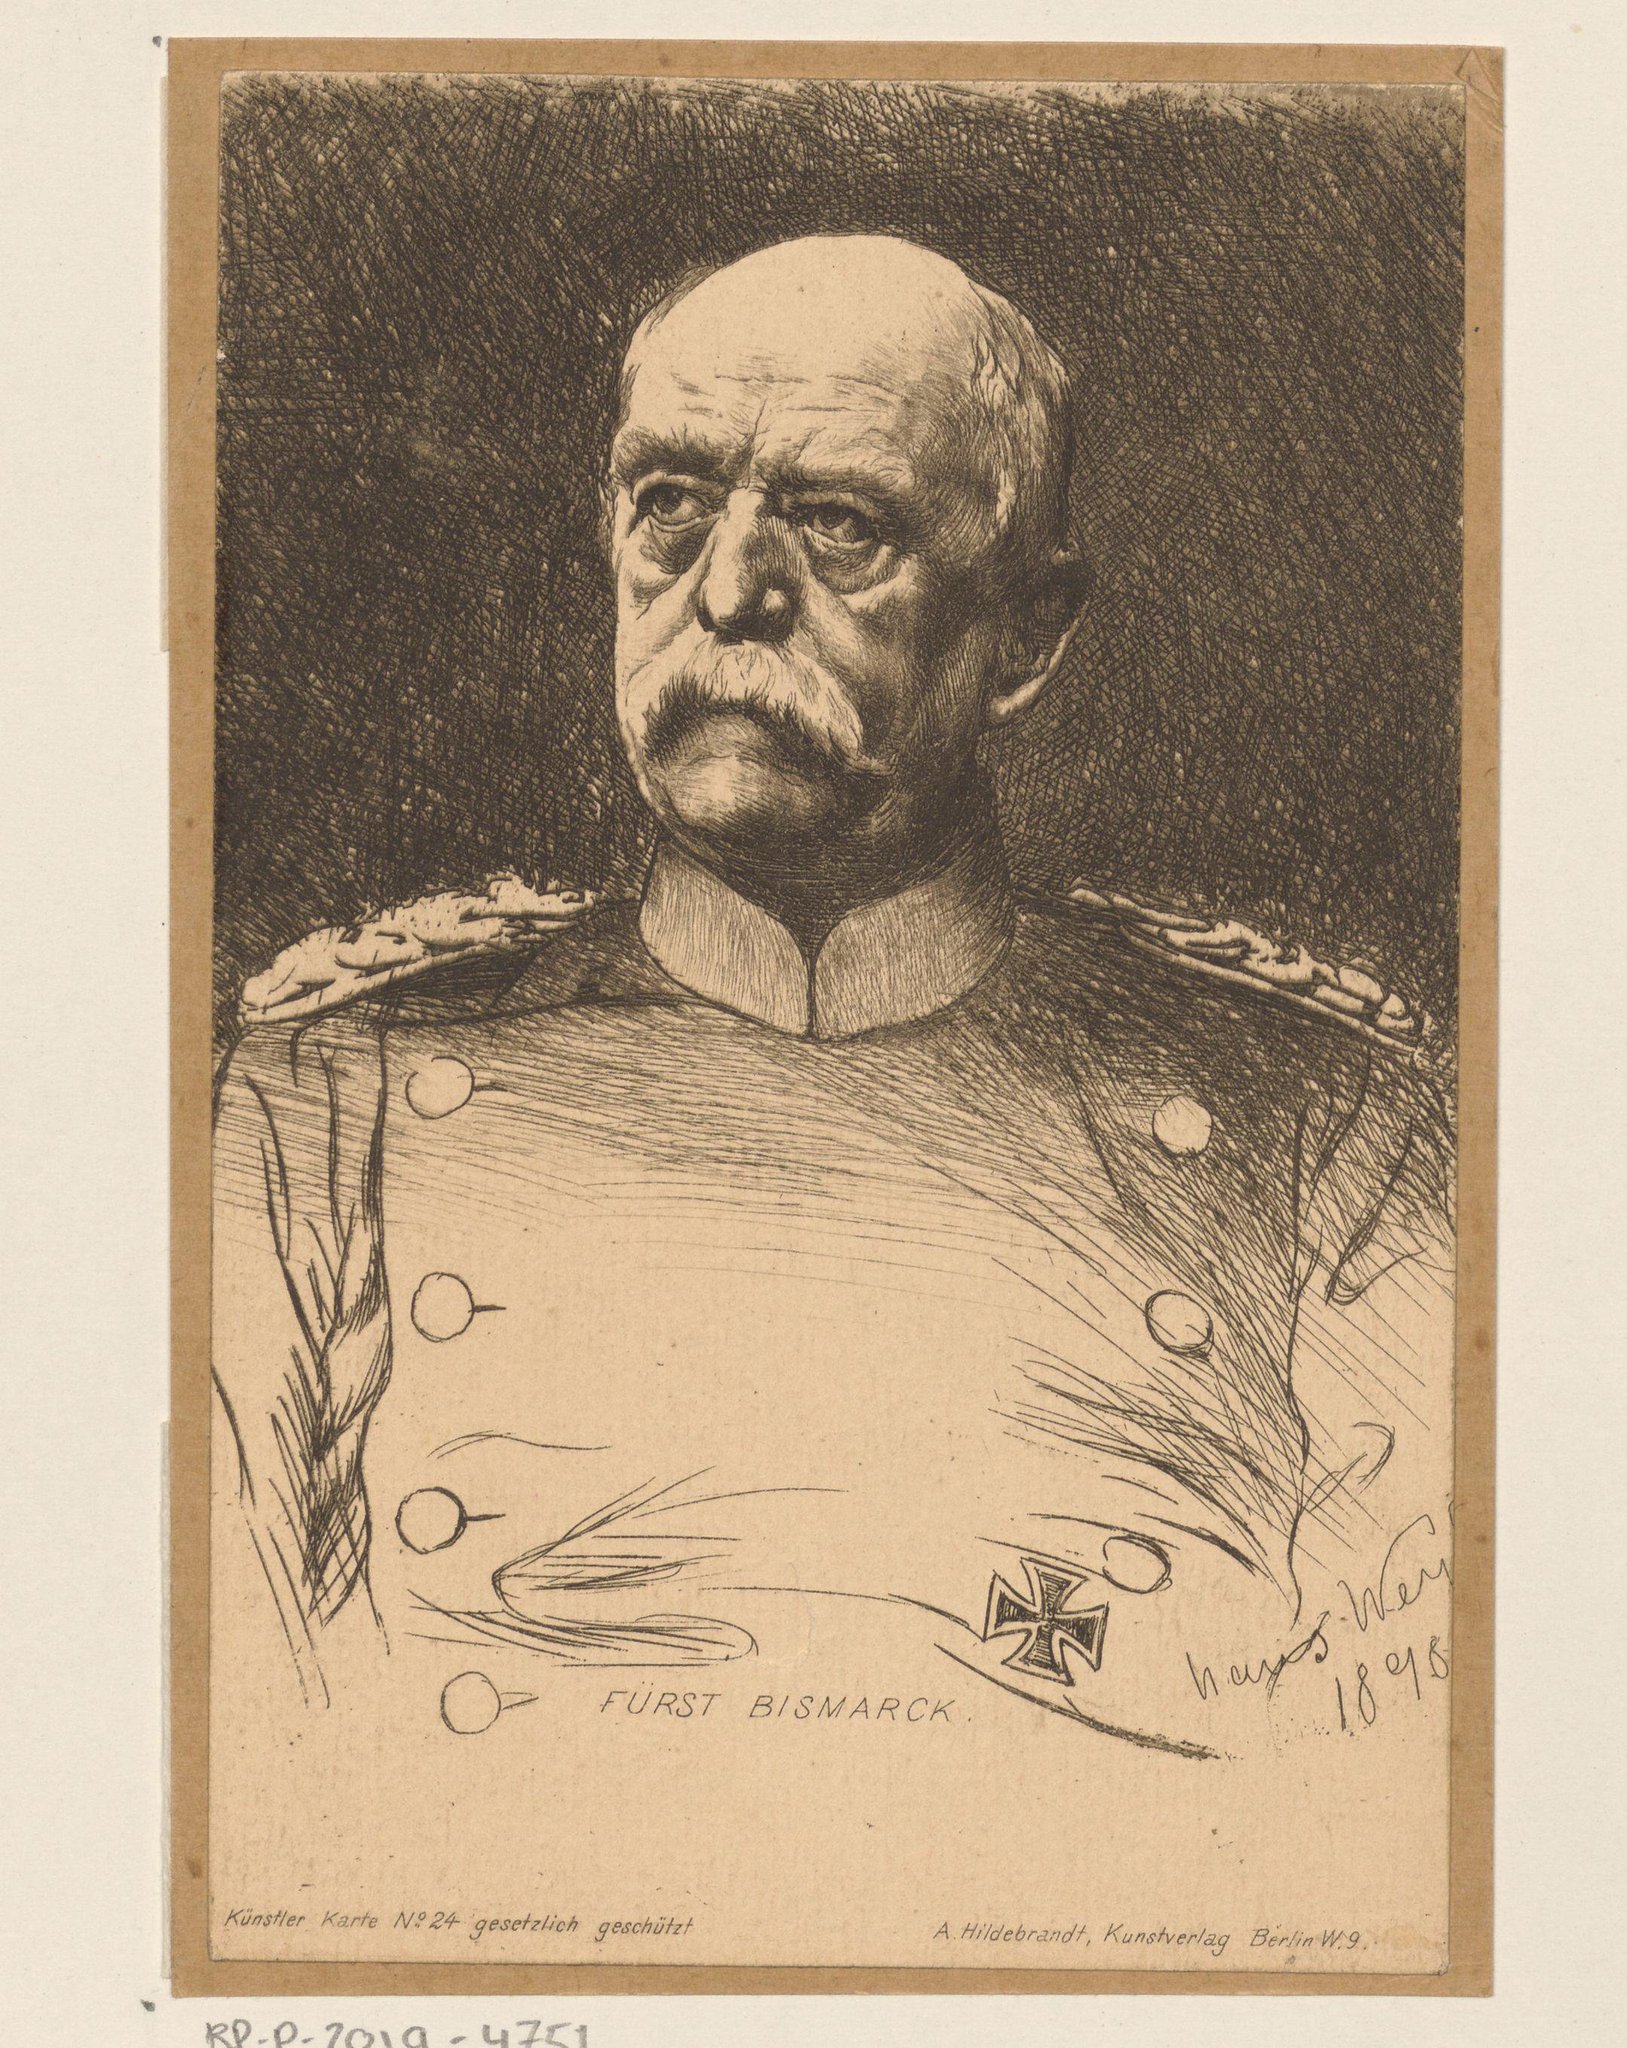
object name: ansichtkaart, prentbriefkaart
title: Portret van Otto von Bismarck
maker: hans weyl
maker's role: painter, print maker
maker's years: 1863-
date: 1898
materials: paper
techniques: drypoint, etching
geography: berlin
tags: historical persons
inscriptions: date